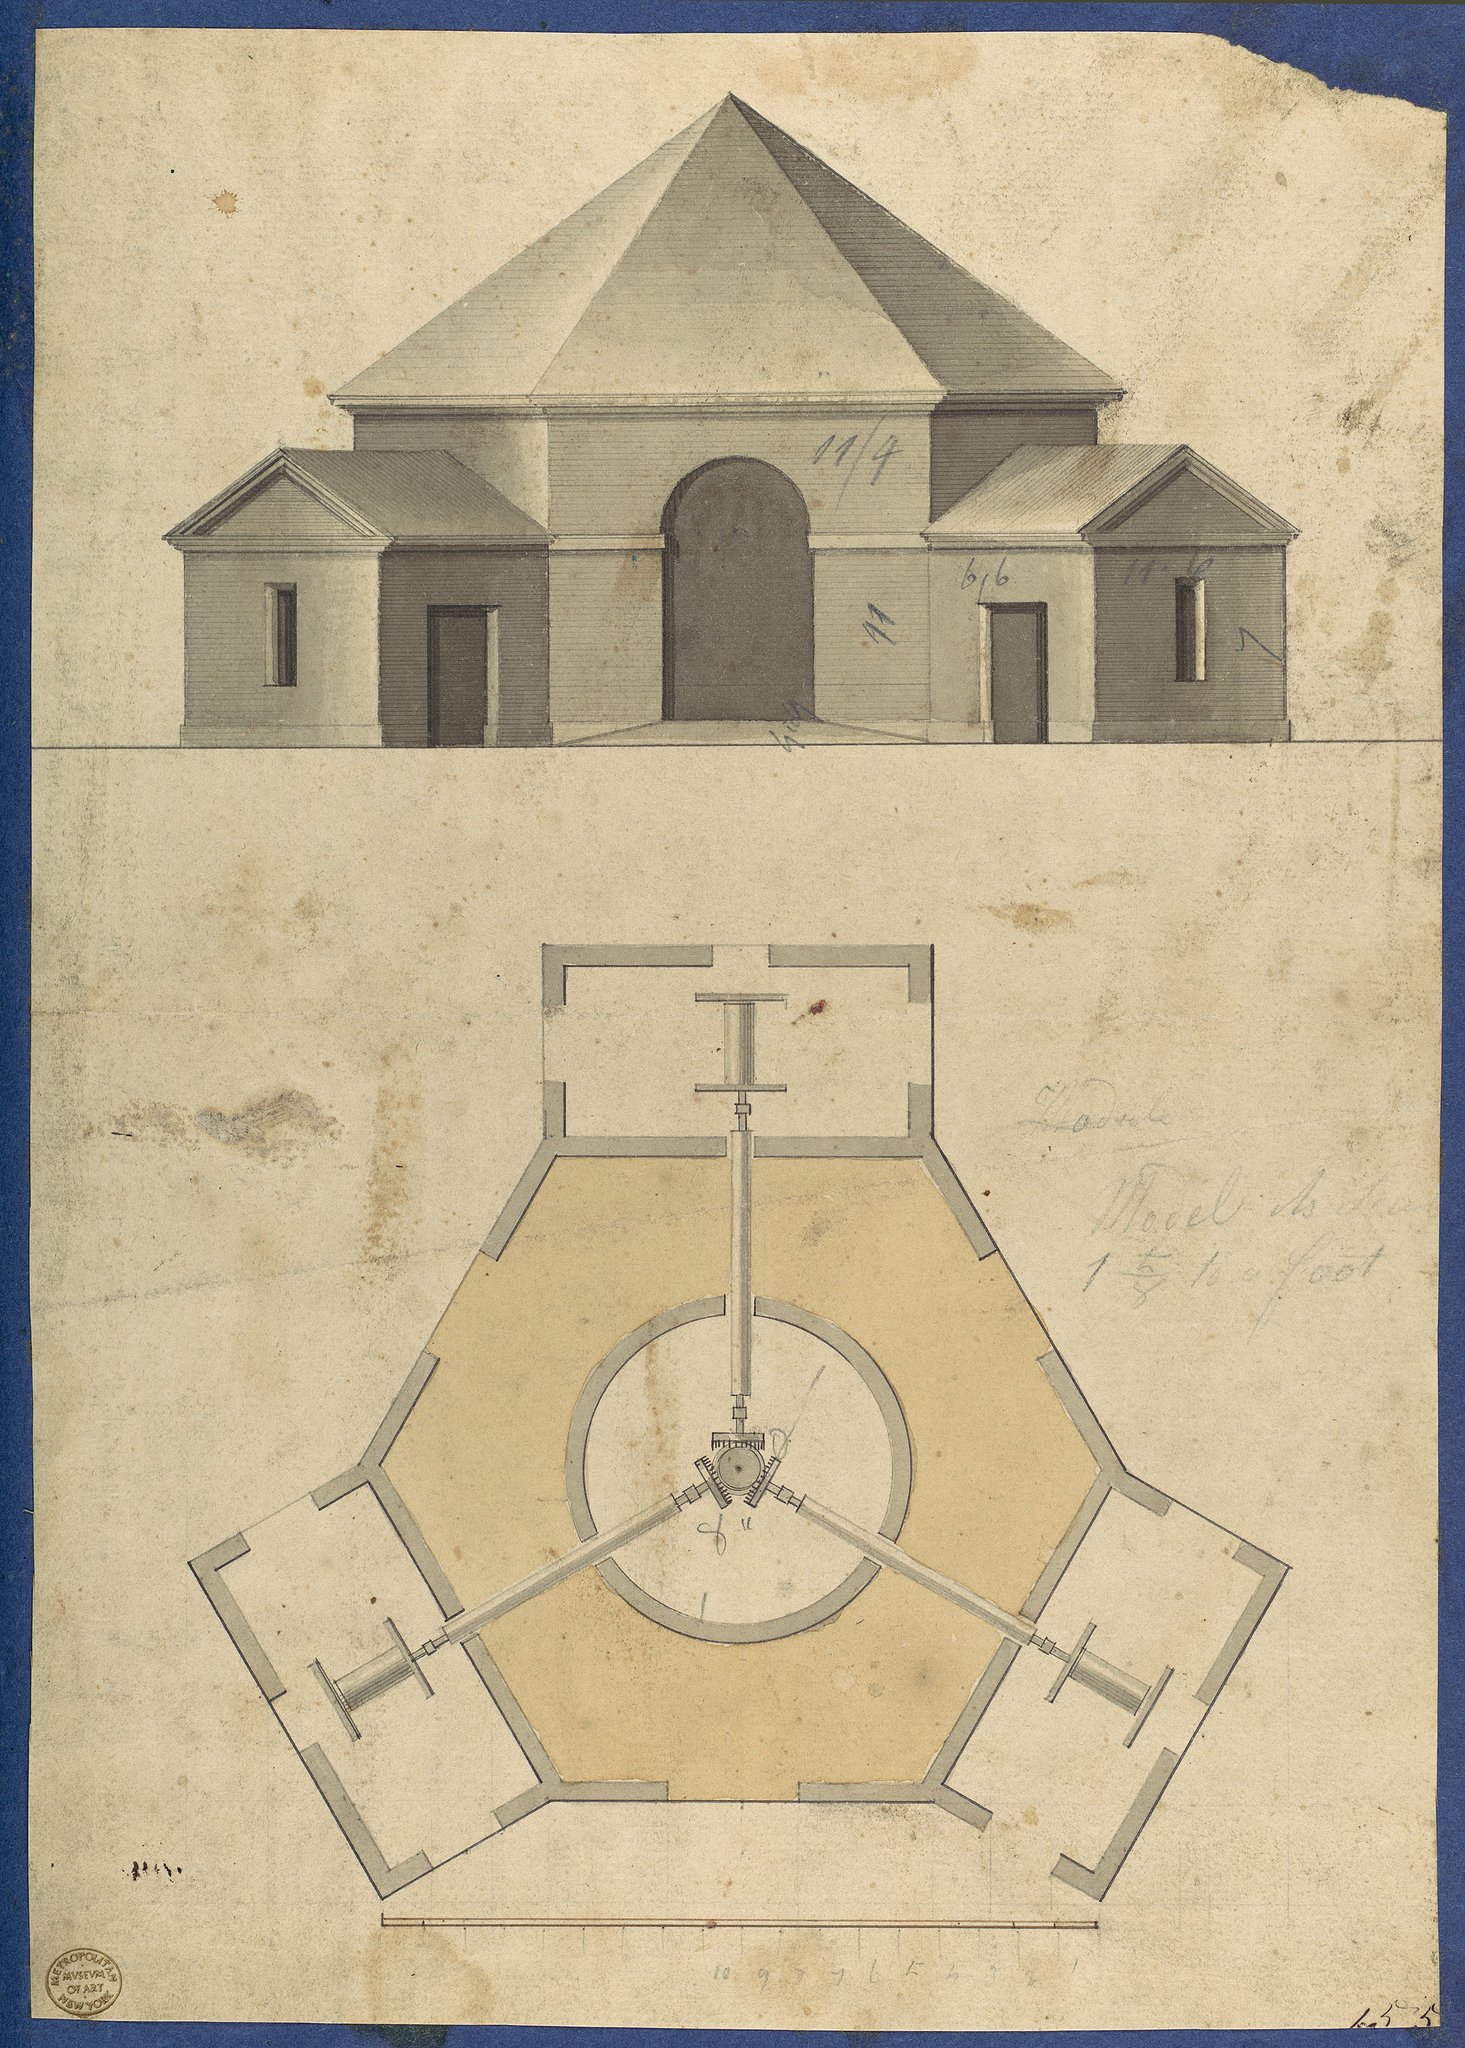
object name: drawing ornament architecture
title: Outbuilding with Three Gears, from Chippendale Drawings, Vol. II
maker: thomas chippendale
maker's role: artist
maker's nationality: british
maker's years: 1718-1779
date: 1760-1800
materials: ink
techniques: wash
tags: architecture,buildings